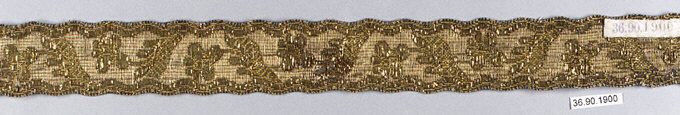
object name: galloon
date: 1767-1833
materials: silk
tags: flowers